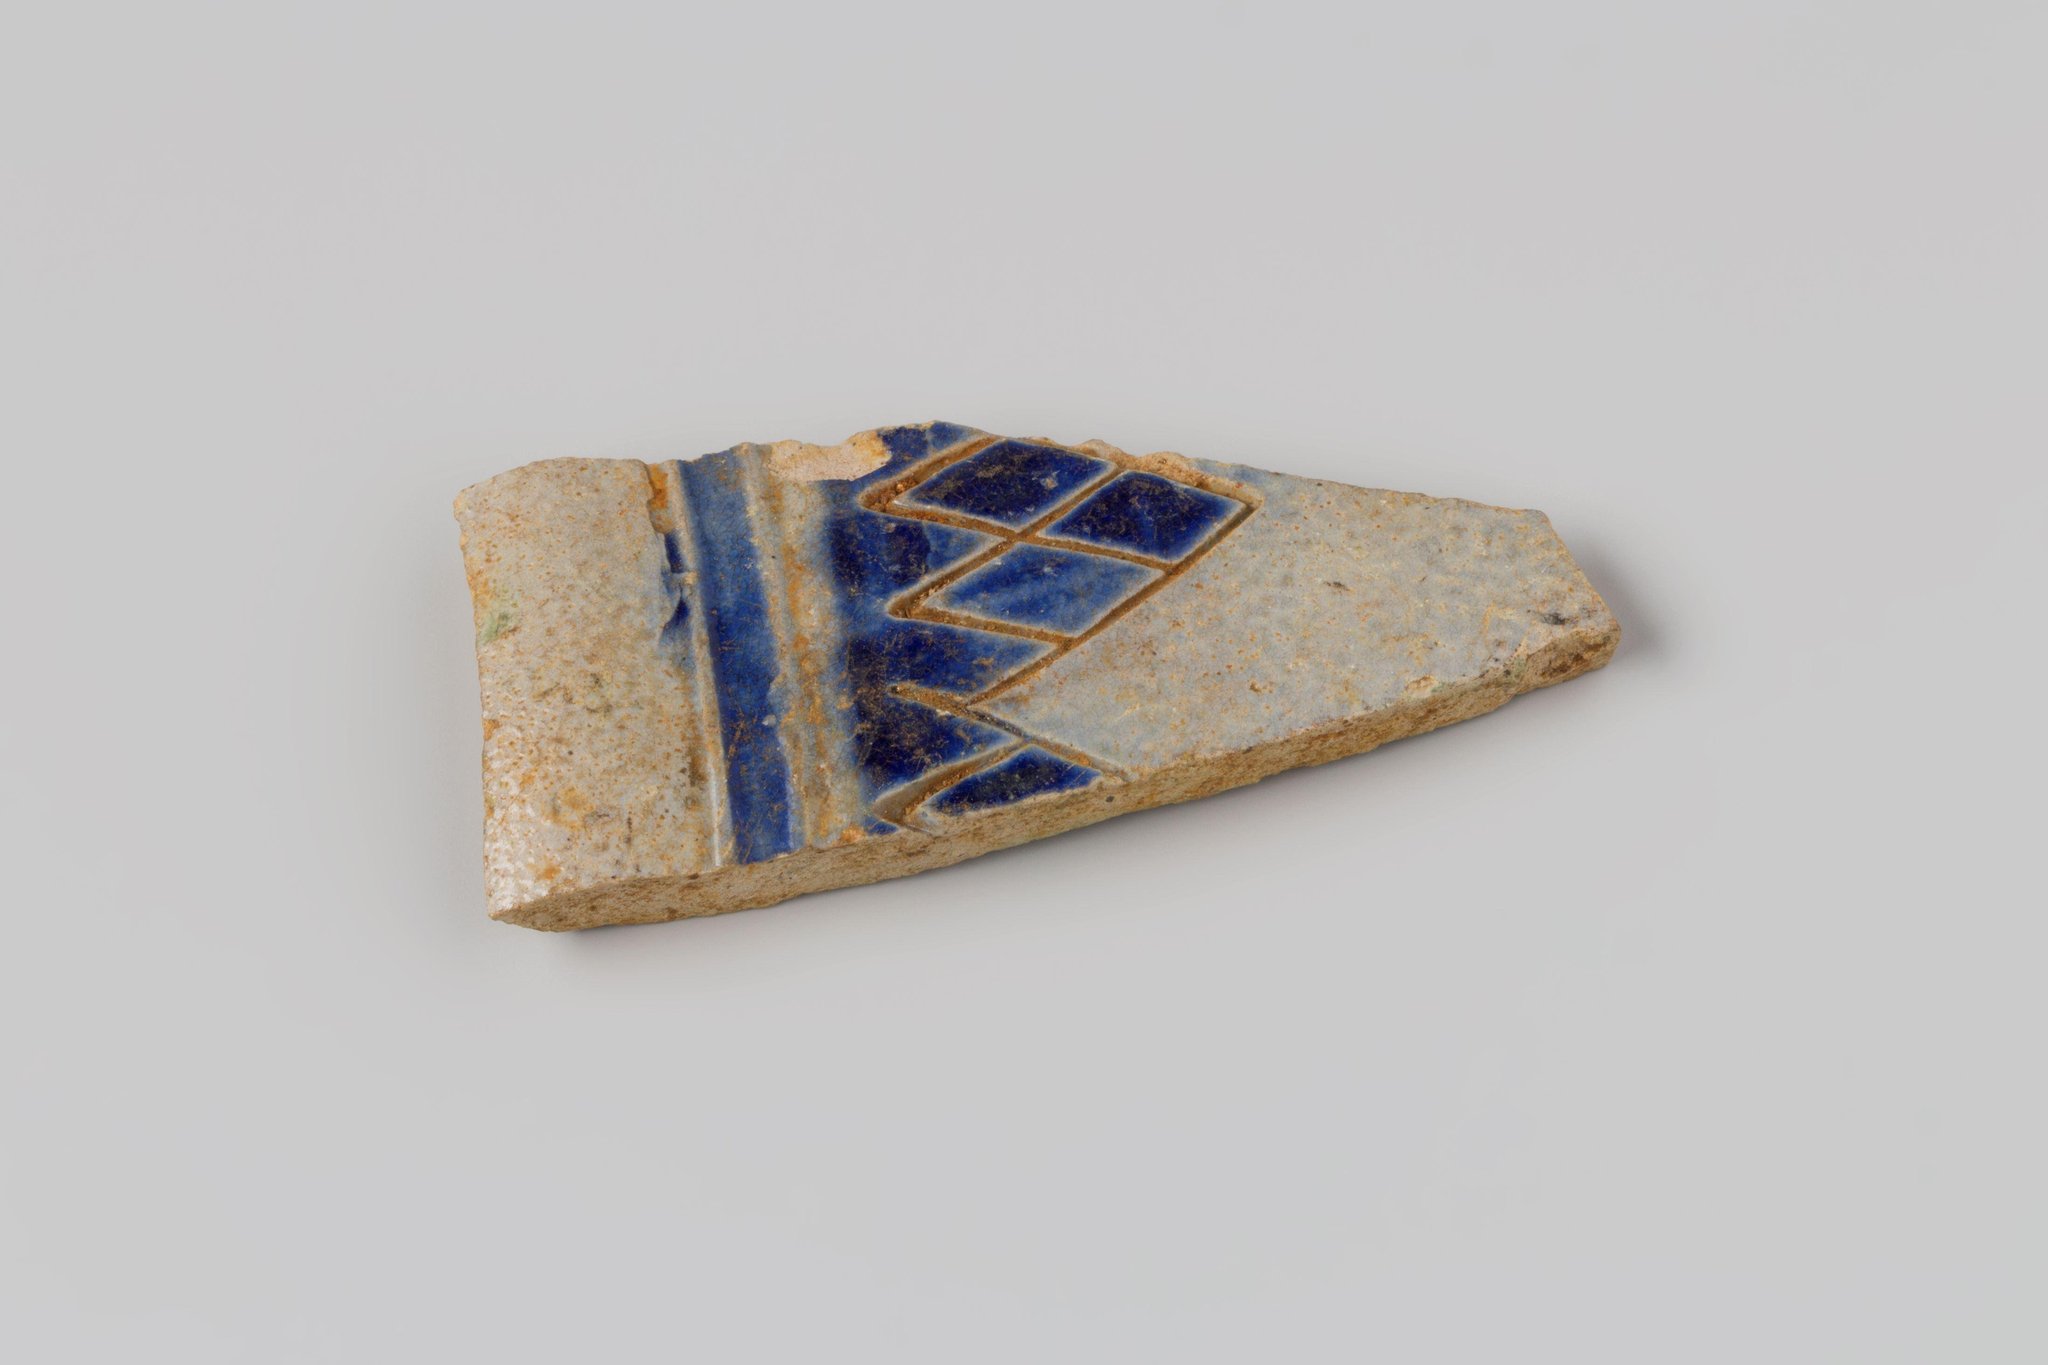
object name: sherd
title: Scherf van een pot uit het wrak van de Oost-Indiëvaarder Hollandia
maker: Anonymous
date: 1700-1743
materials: stoneware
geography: westerwald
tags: verenigde oostindische compagnie, hollandia (schip), annet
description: Stoneware, Rhenish, Westerwald, pot; of body, sim. NG 1980-27H2624r.